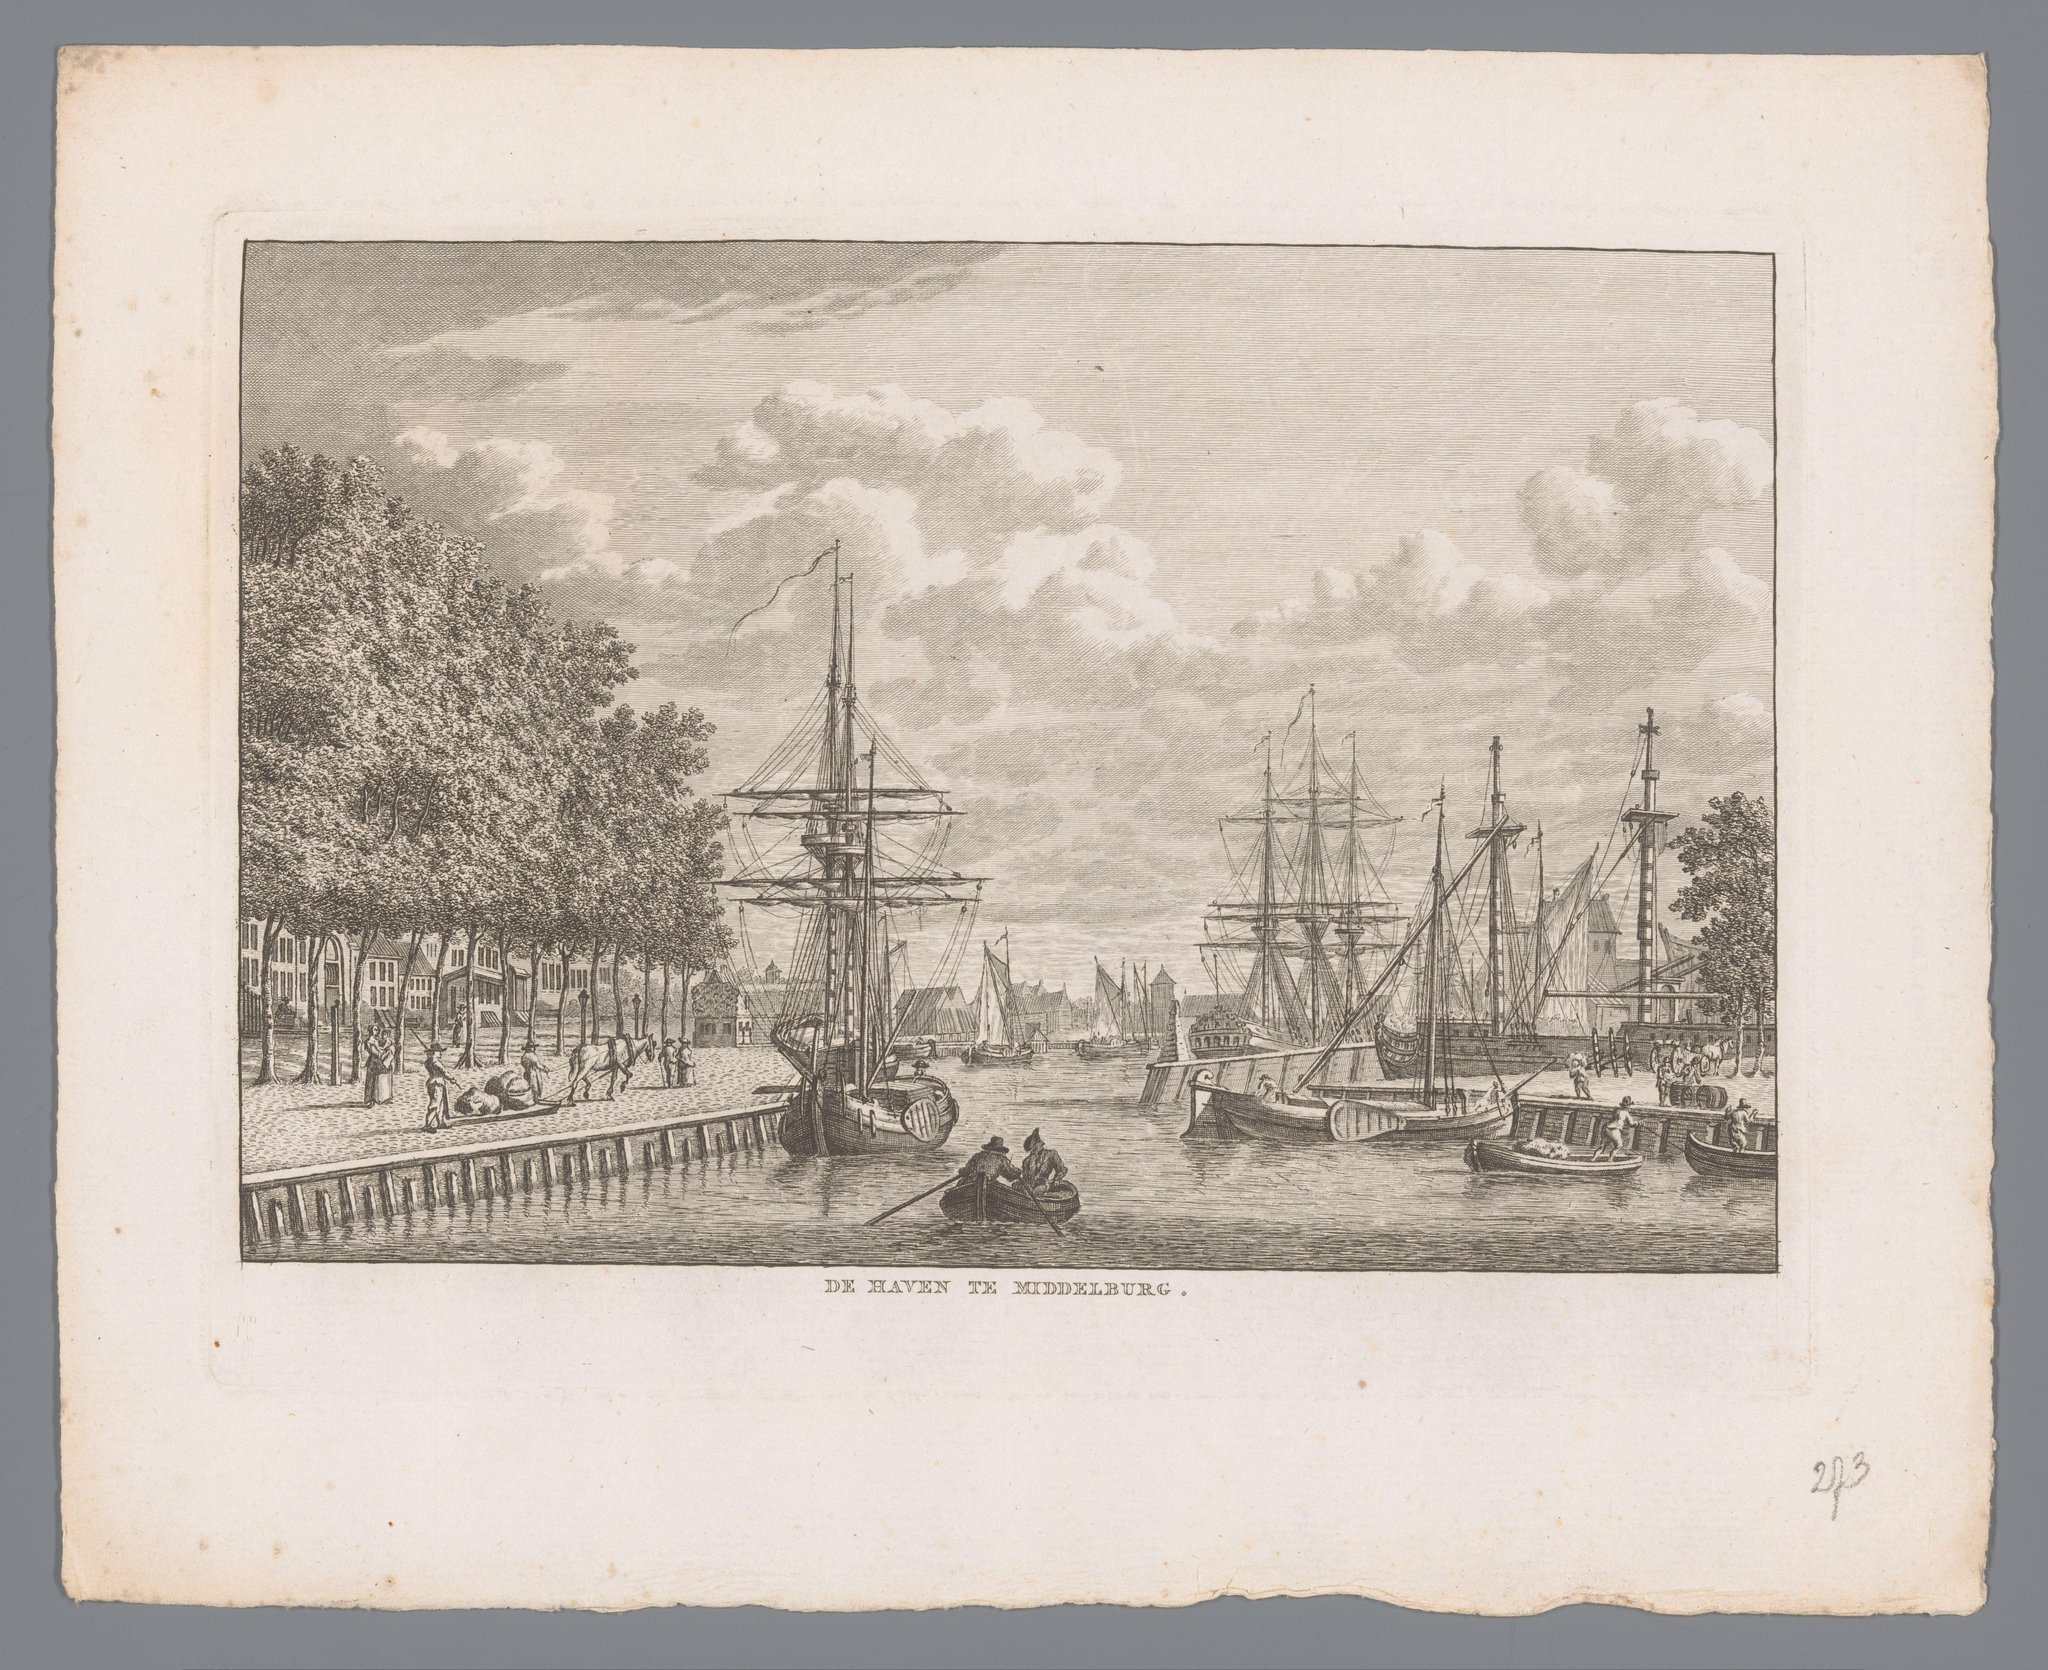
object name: print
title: De Haven te Middelburg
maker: carel frederik bendorp (i)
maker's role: print maker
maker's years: 1736-1814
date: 1786-1792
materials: paper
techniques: etching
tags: street (+ city(-scape) with figures, staffage), harbour (+ number of persons ~ traffic and transport), middelburg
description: Prent uit: Vaderlandsche gezichten, of afbeeldingen van den tegenwoordigen staat der Vereenigde Nederlanden (…). Amsterdam: Hendrik Gartman, Willem Vermandel en Jan Willem Smit, 1786-1792. Uitgegeven in afleveringen met ieder een eigen bifolium en inhoudsopgave. Alle prenten in deze publicatie zijn gegraveerd door Carel Frederik Bendorp (I) en, in de meeste gevallen, gebaseerd op tekeningen van Jan Bulthuis.